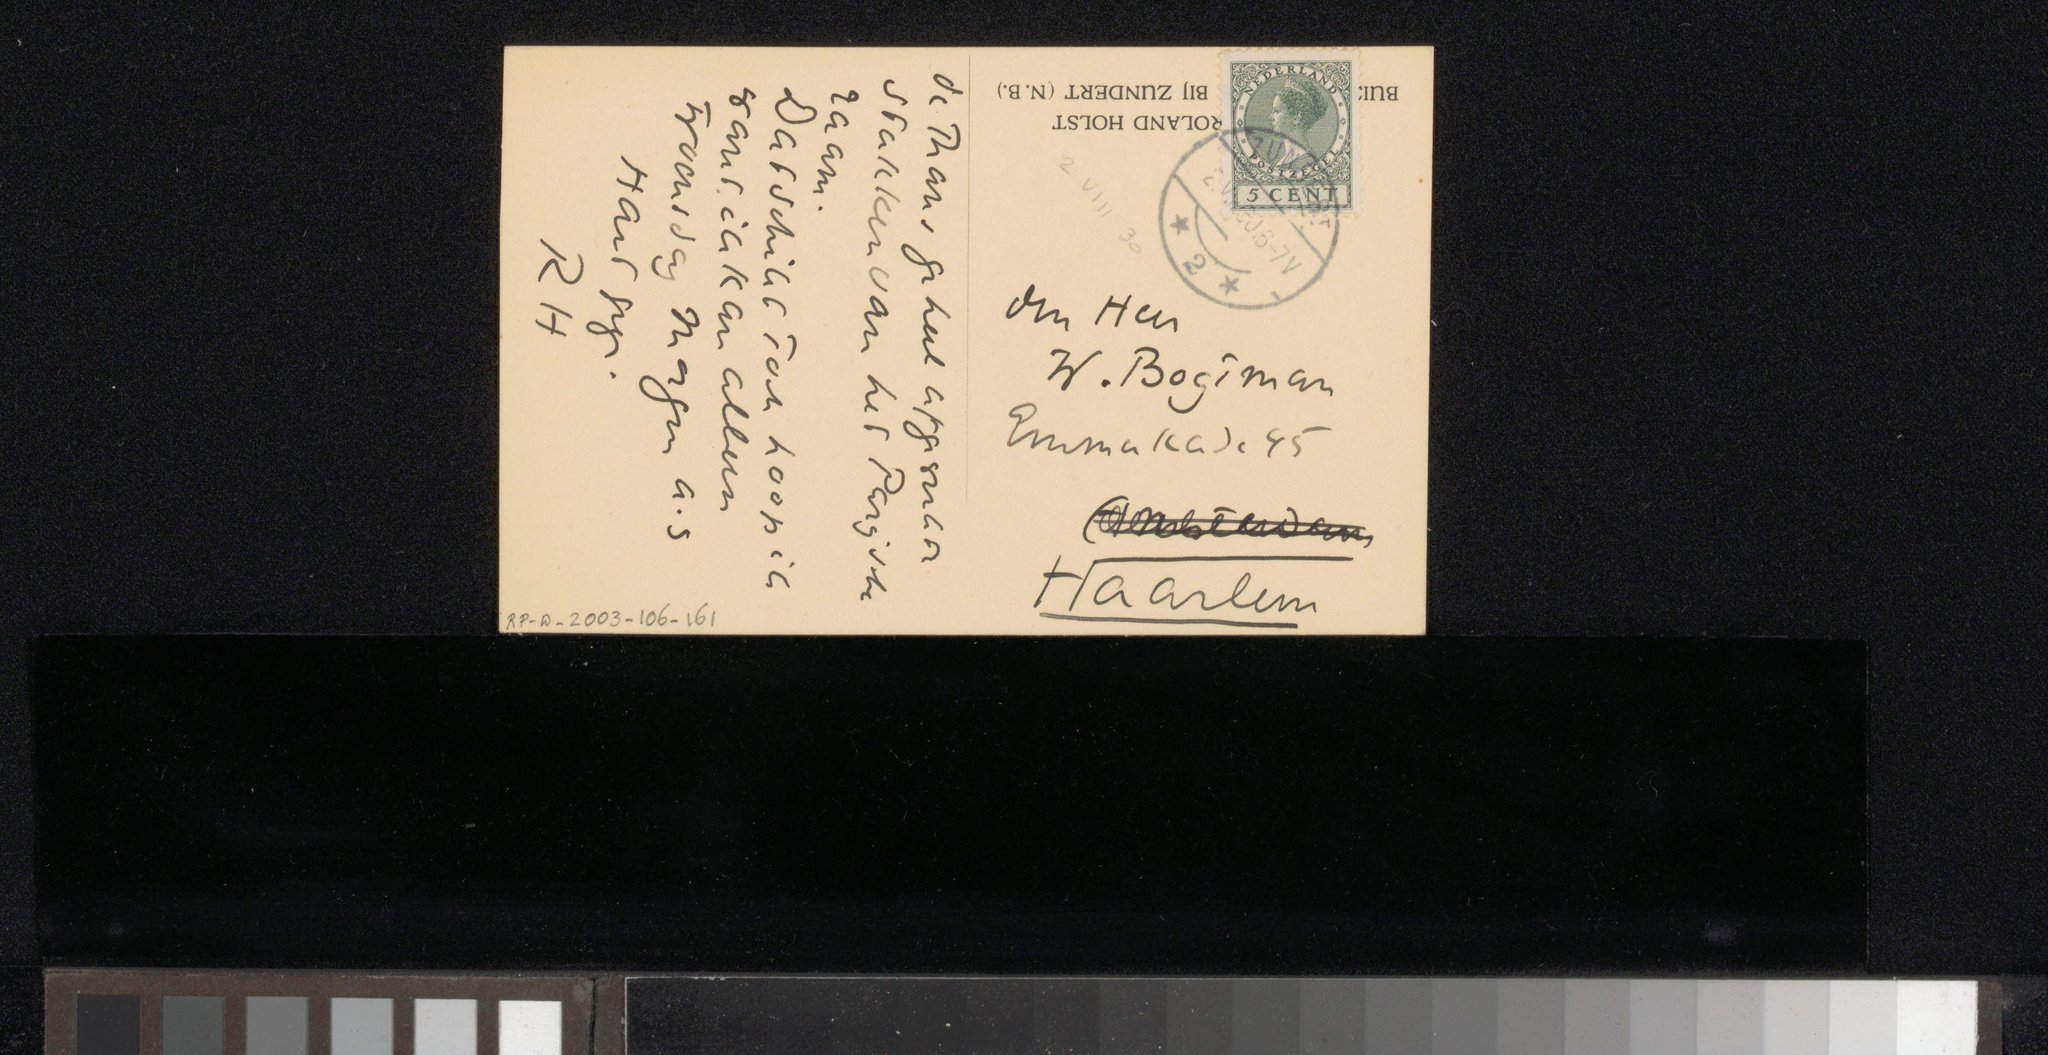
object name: postcard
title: Briefkaart aan Willem Bogtman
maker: richard nicolaüs roland holst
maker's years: 1868-1938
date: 1930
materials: cardboard, ink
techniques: pen, writing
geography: zundert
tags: haarlem, willem bogtman, applied arts, arts and crafts; industrial design, paris, amsterdam